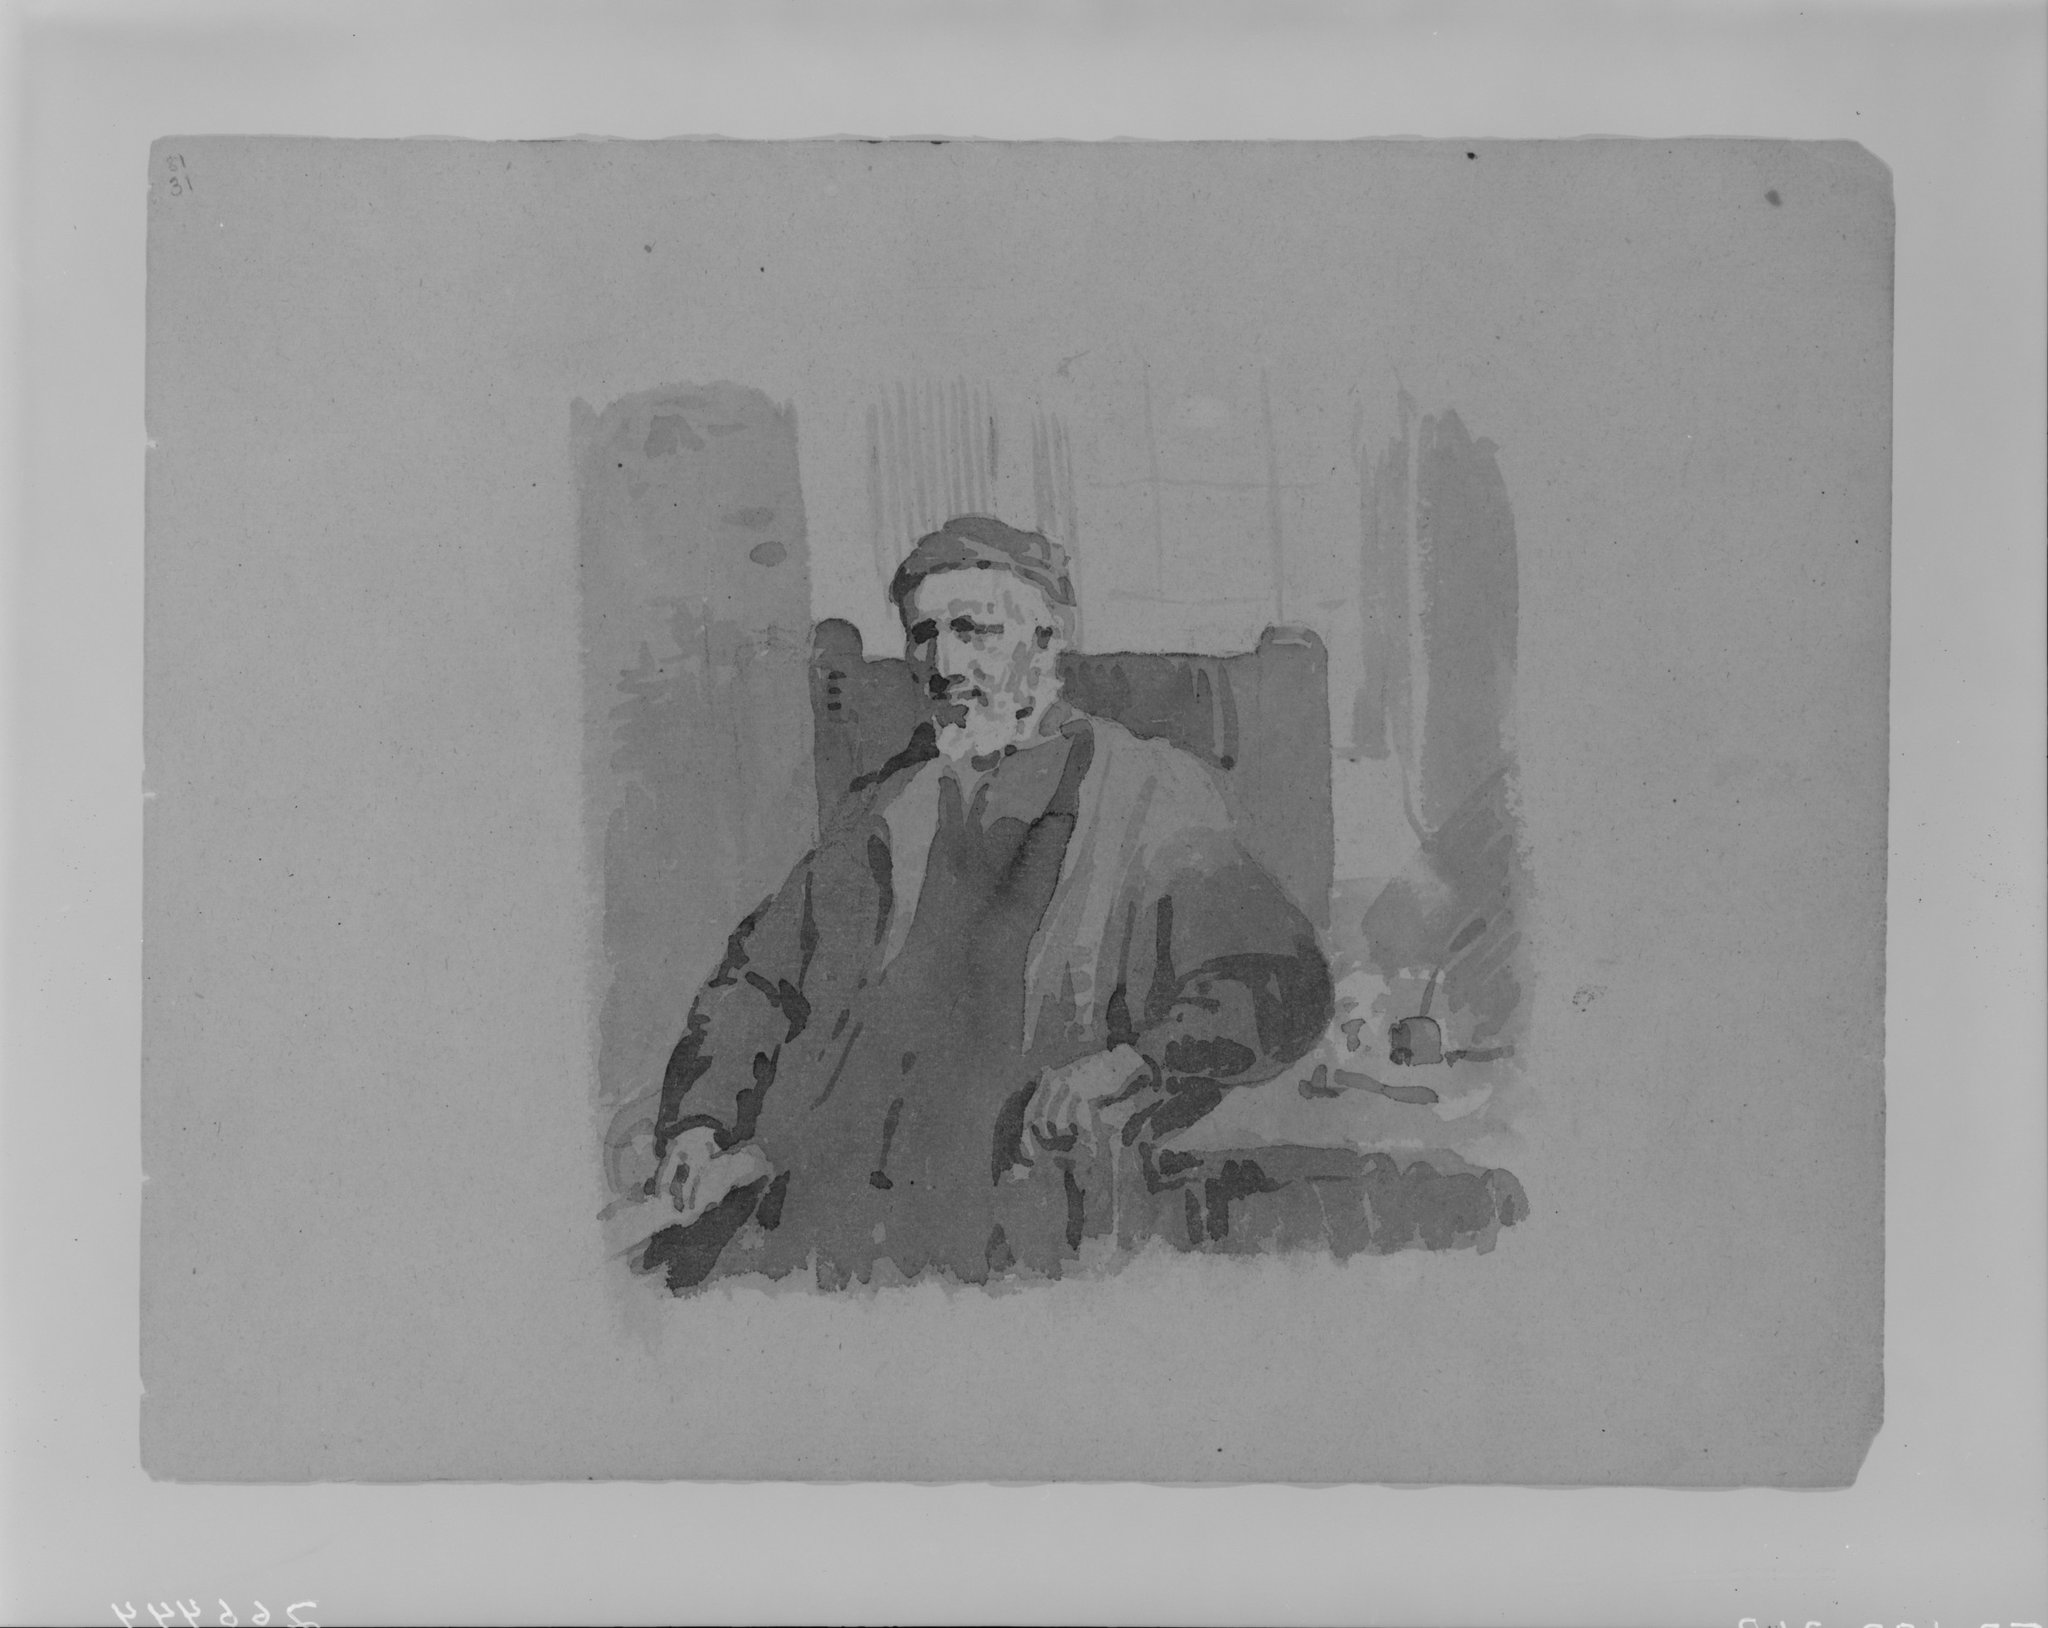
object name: drawing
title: Bearded Cleric (from Sketchbook)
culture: american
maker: thomas sully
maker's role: artist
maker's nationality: american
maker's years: 1783-1872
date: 1810-1820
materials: ink, paper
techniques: wash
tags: men